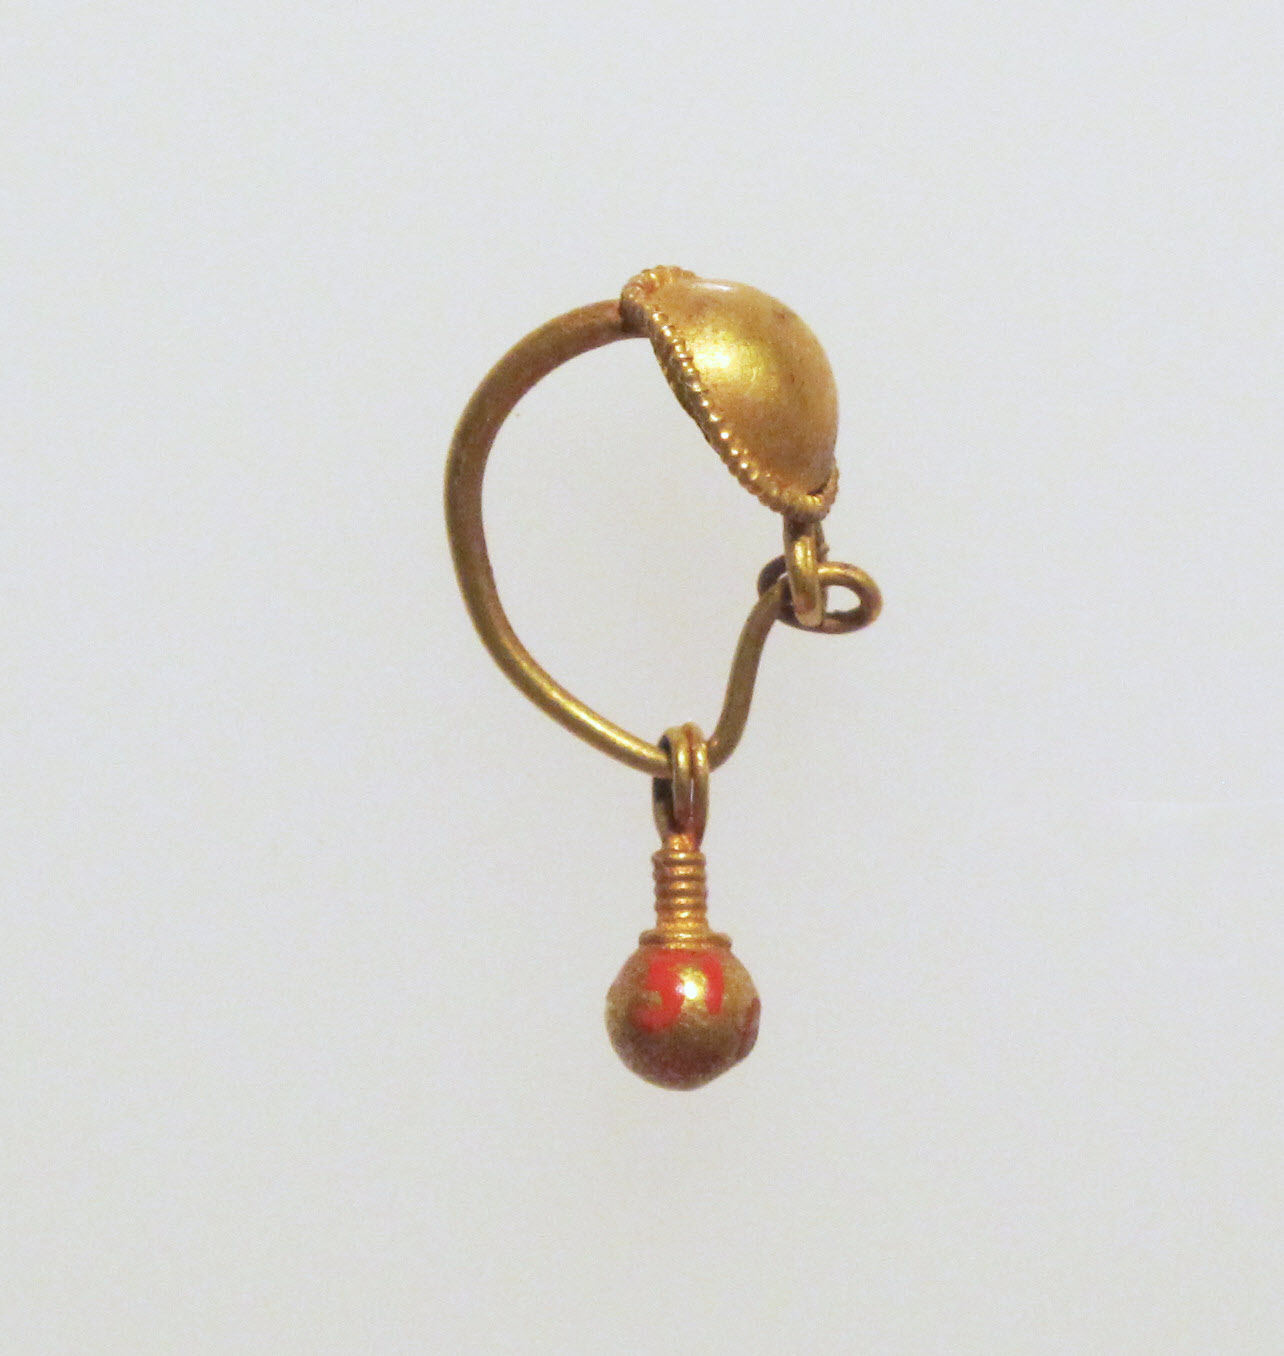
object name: earring with pendant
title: Gold earring with disc and pendant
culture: roman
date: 31 BCE-330 CE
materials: gold